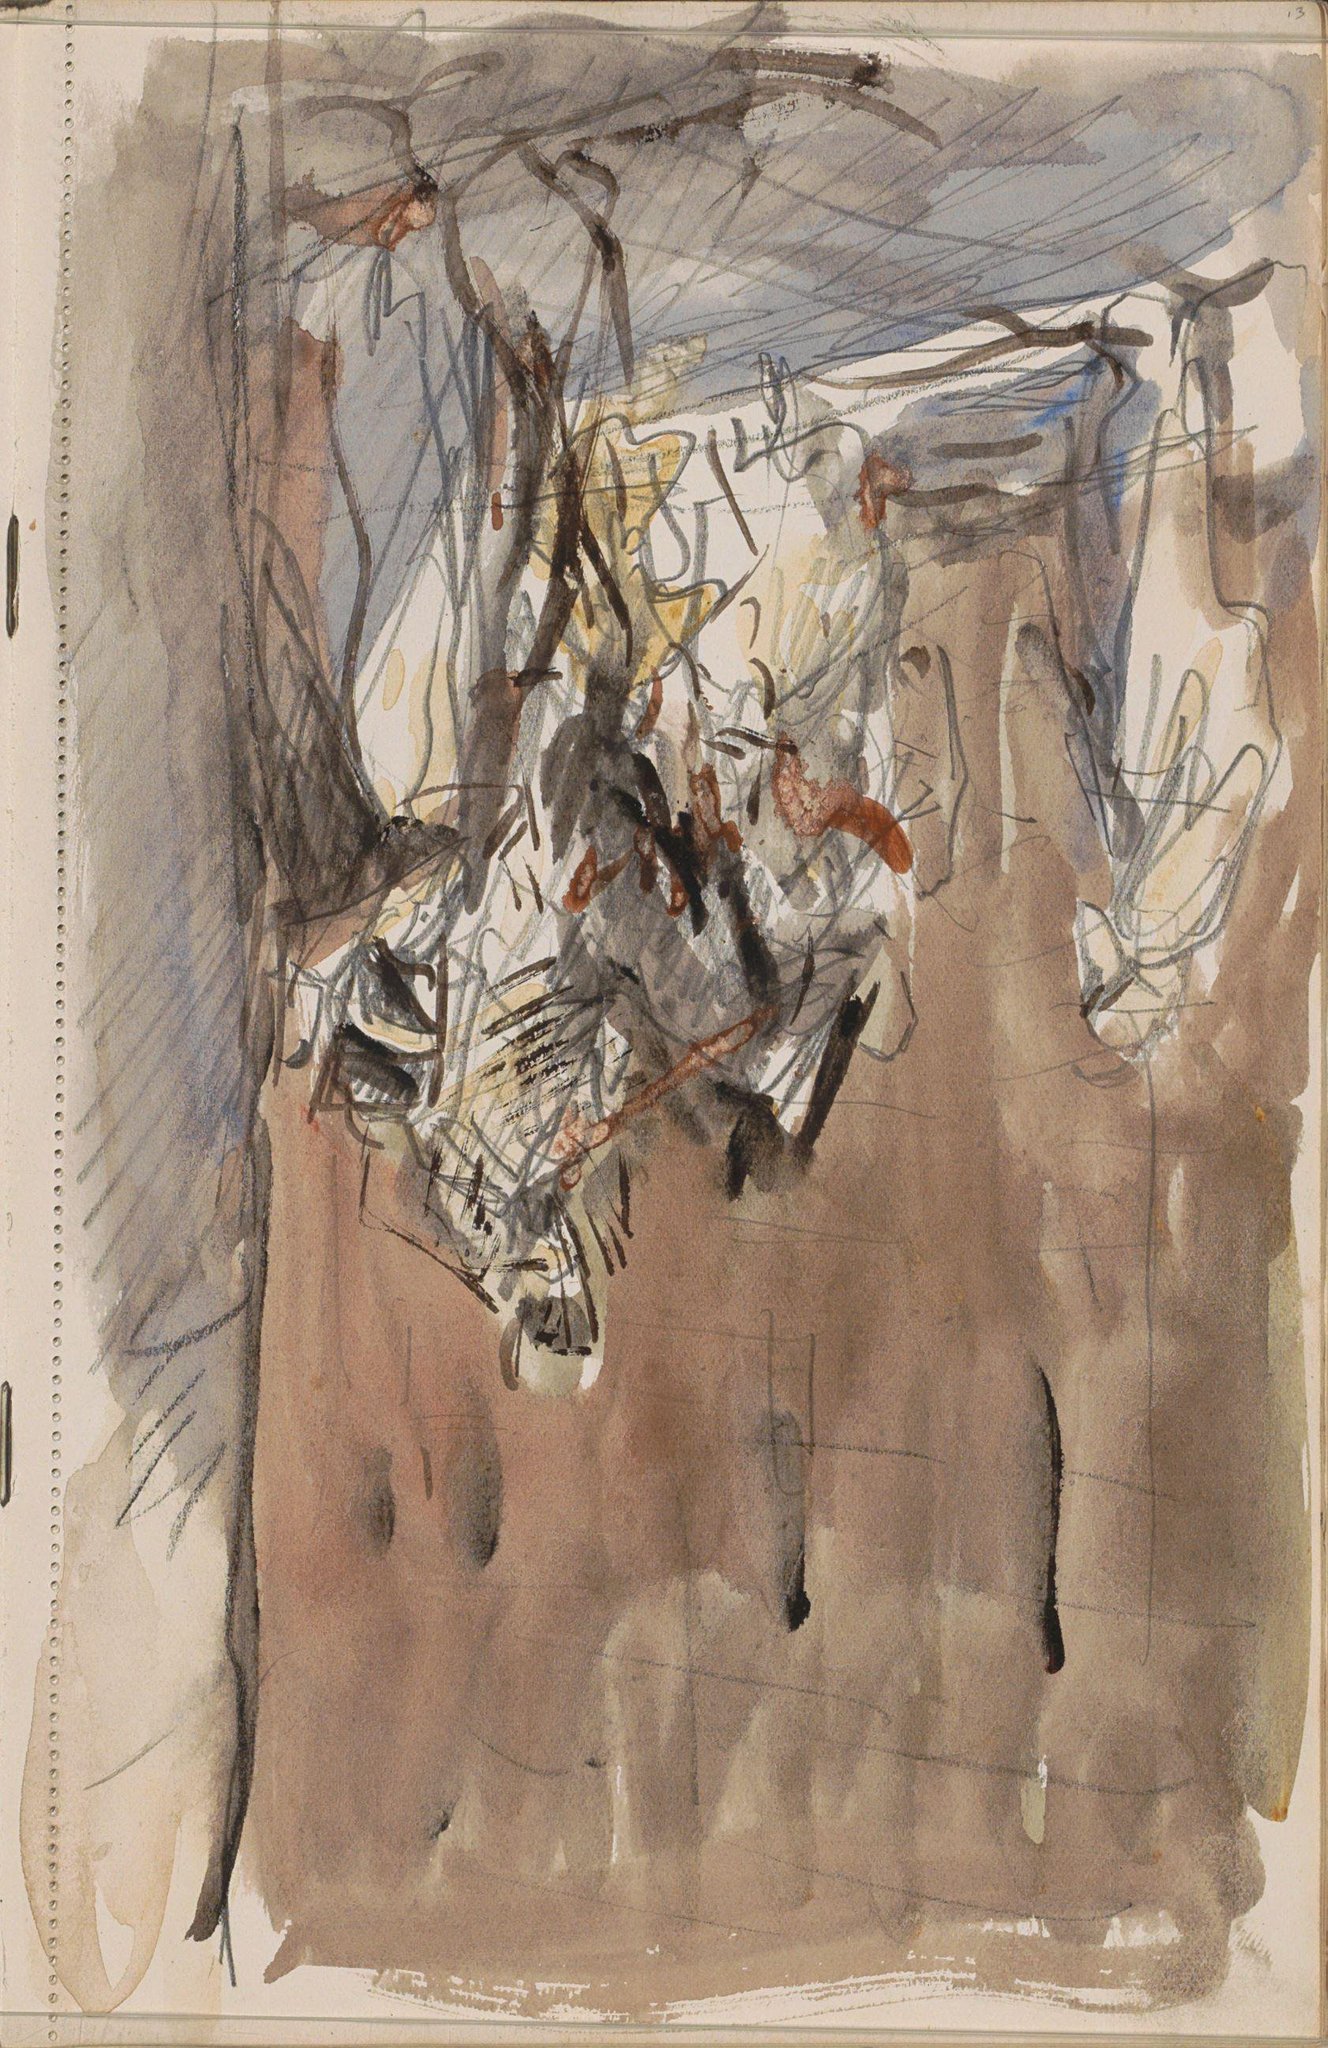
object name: sketchbook leaf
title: Straat met figuren, waaronder een ruiter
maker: marius bauer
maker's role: draughtsman, print maker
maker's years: 1867-1932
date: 1923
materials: chalk, paper, pencil, watercolor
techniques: brush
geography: morocco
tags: riding a horse, ass, or mule; rider, horseman, street (+ city(-scape) with figures, staffage)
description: Pagina 13 uit een schetsboek met 66 bladen.